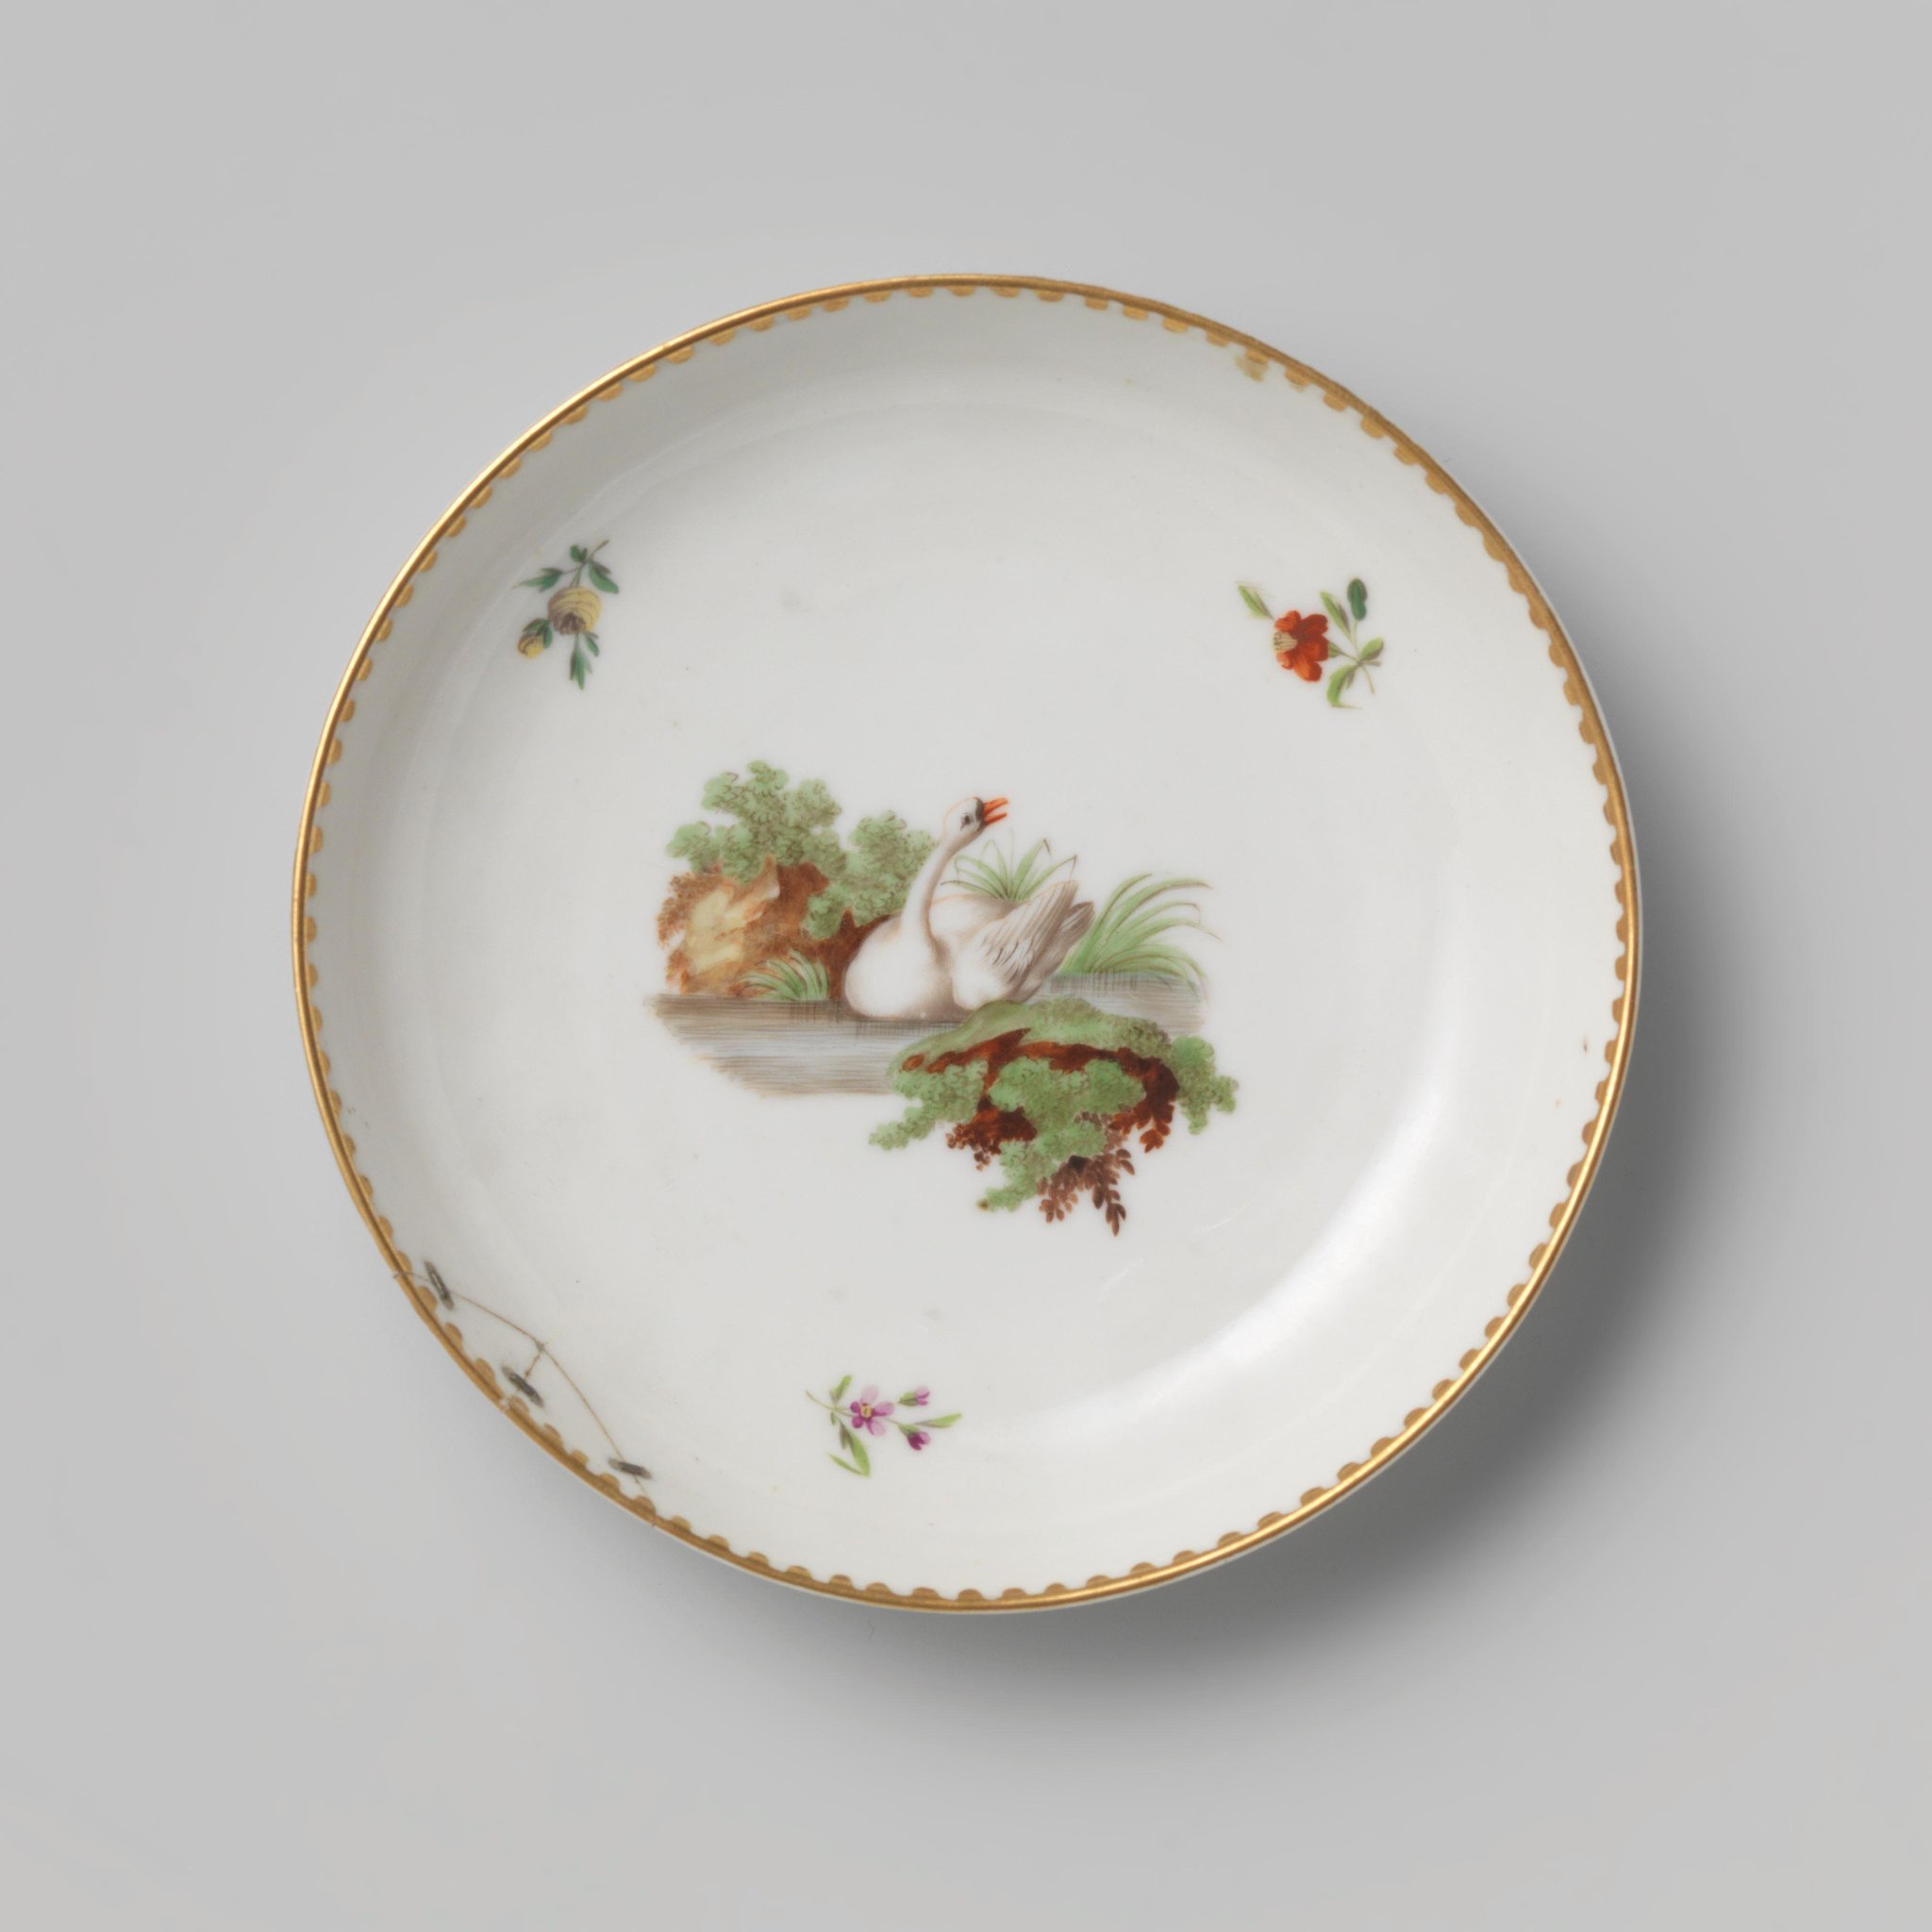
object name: platter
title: Schotel, beschilderd met pluimvee in een landschap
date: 1782-1784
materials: porcelain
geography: loosdrecht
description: Schotel van porselein. Veelkleurig beschilderd met vogels op een landschapsgrondje, en strooibloemen.